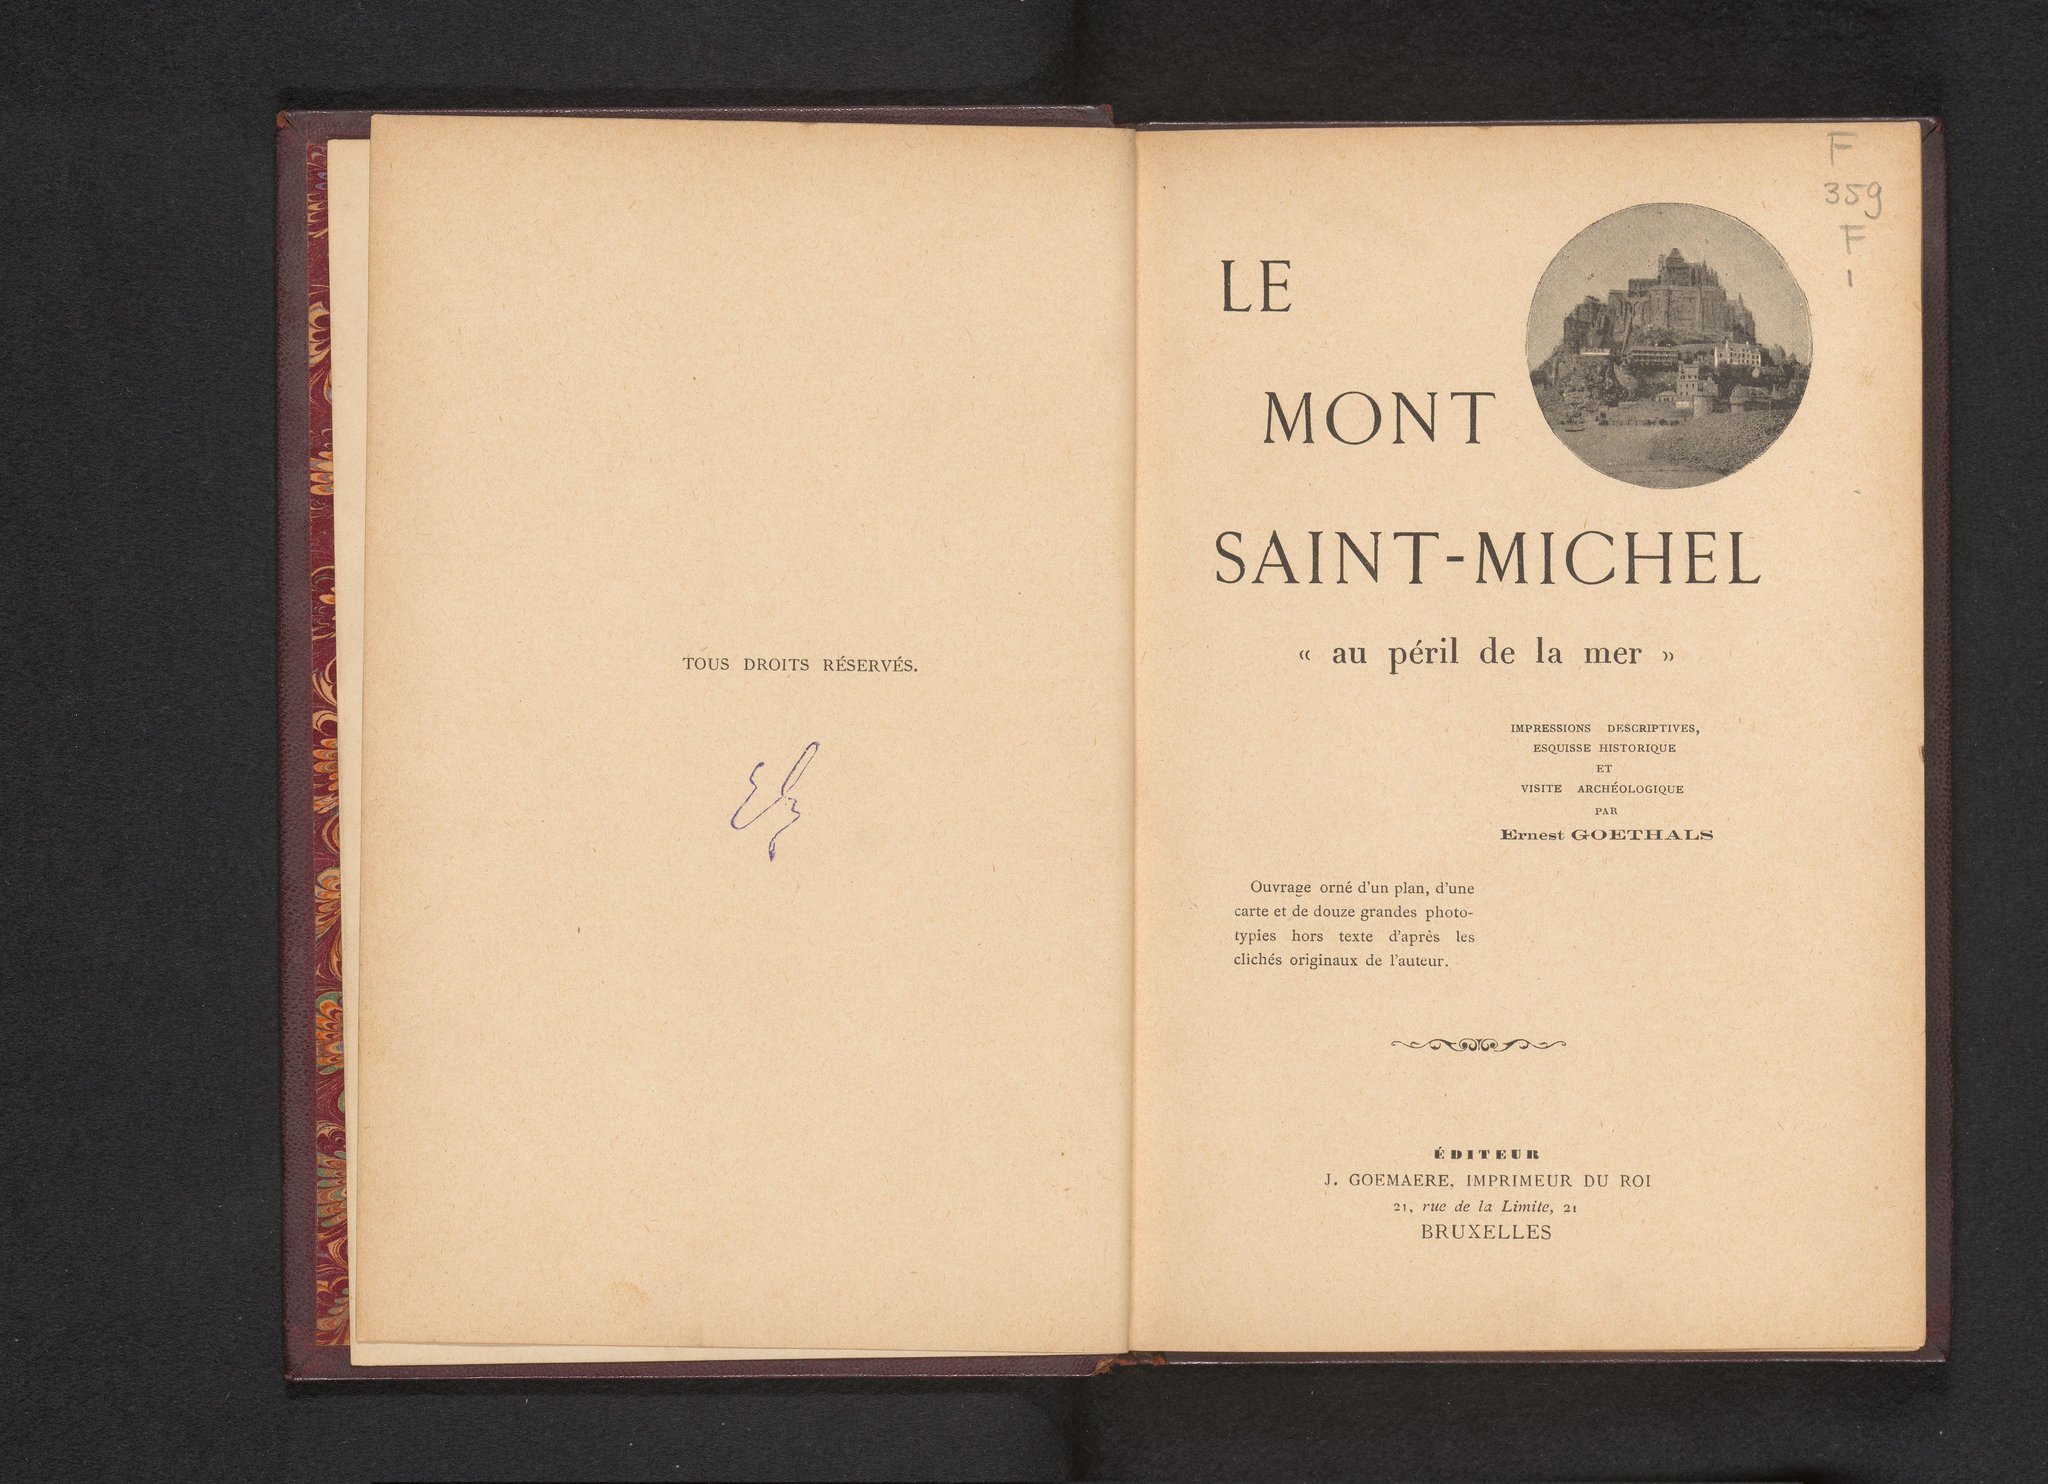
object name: page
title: Gezicht op Mont Saint-Michel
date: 1892-1897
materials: paper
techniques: autotype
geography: france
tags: city-view in general; 'veduta', abbey, monastery, convent ~ roman catholic church